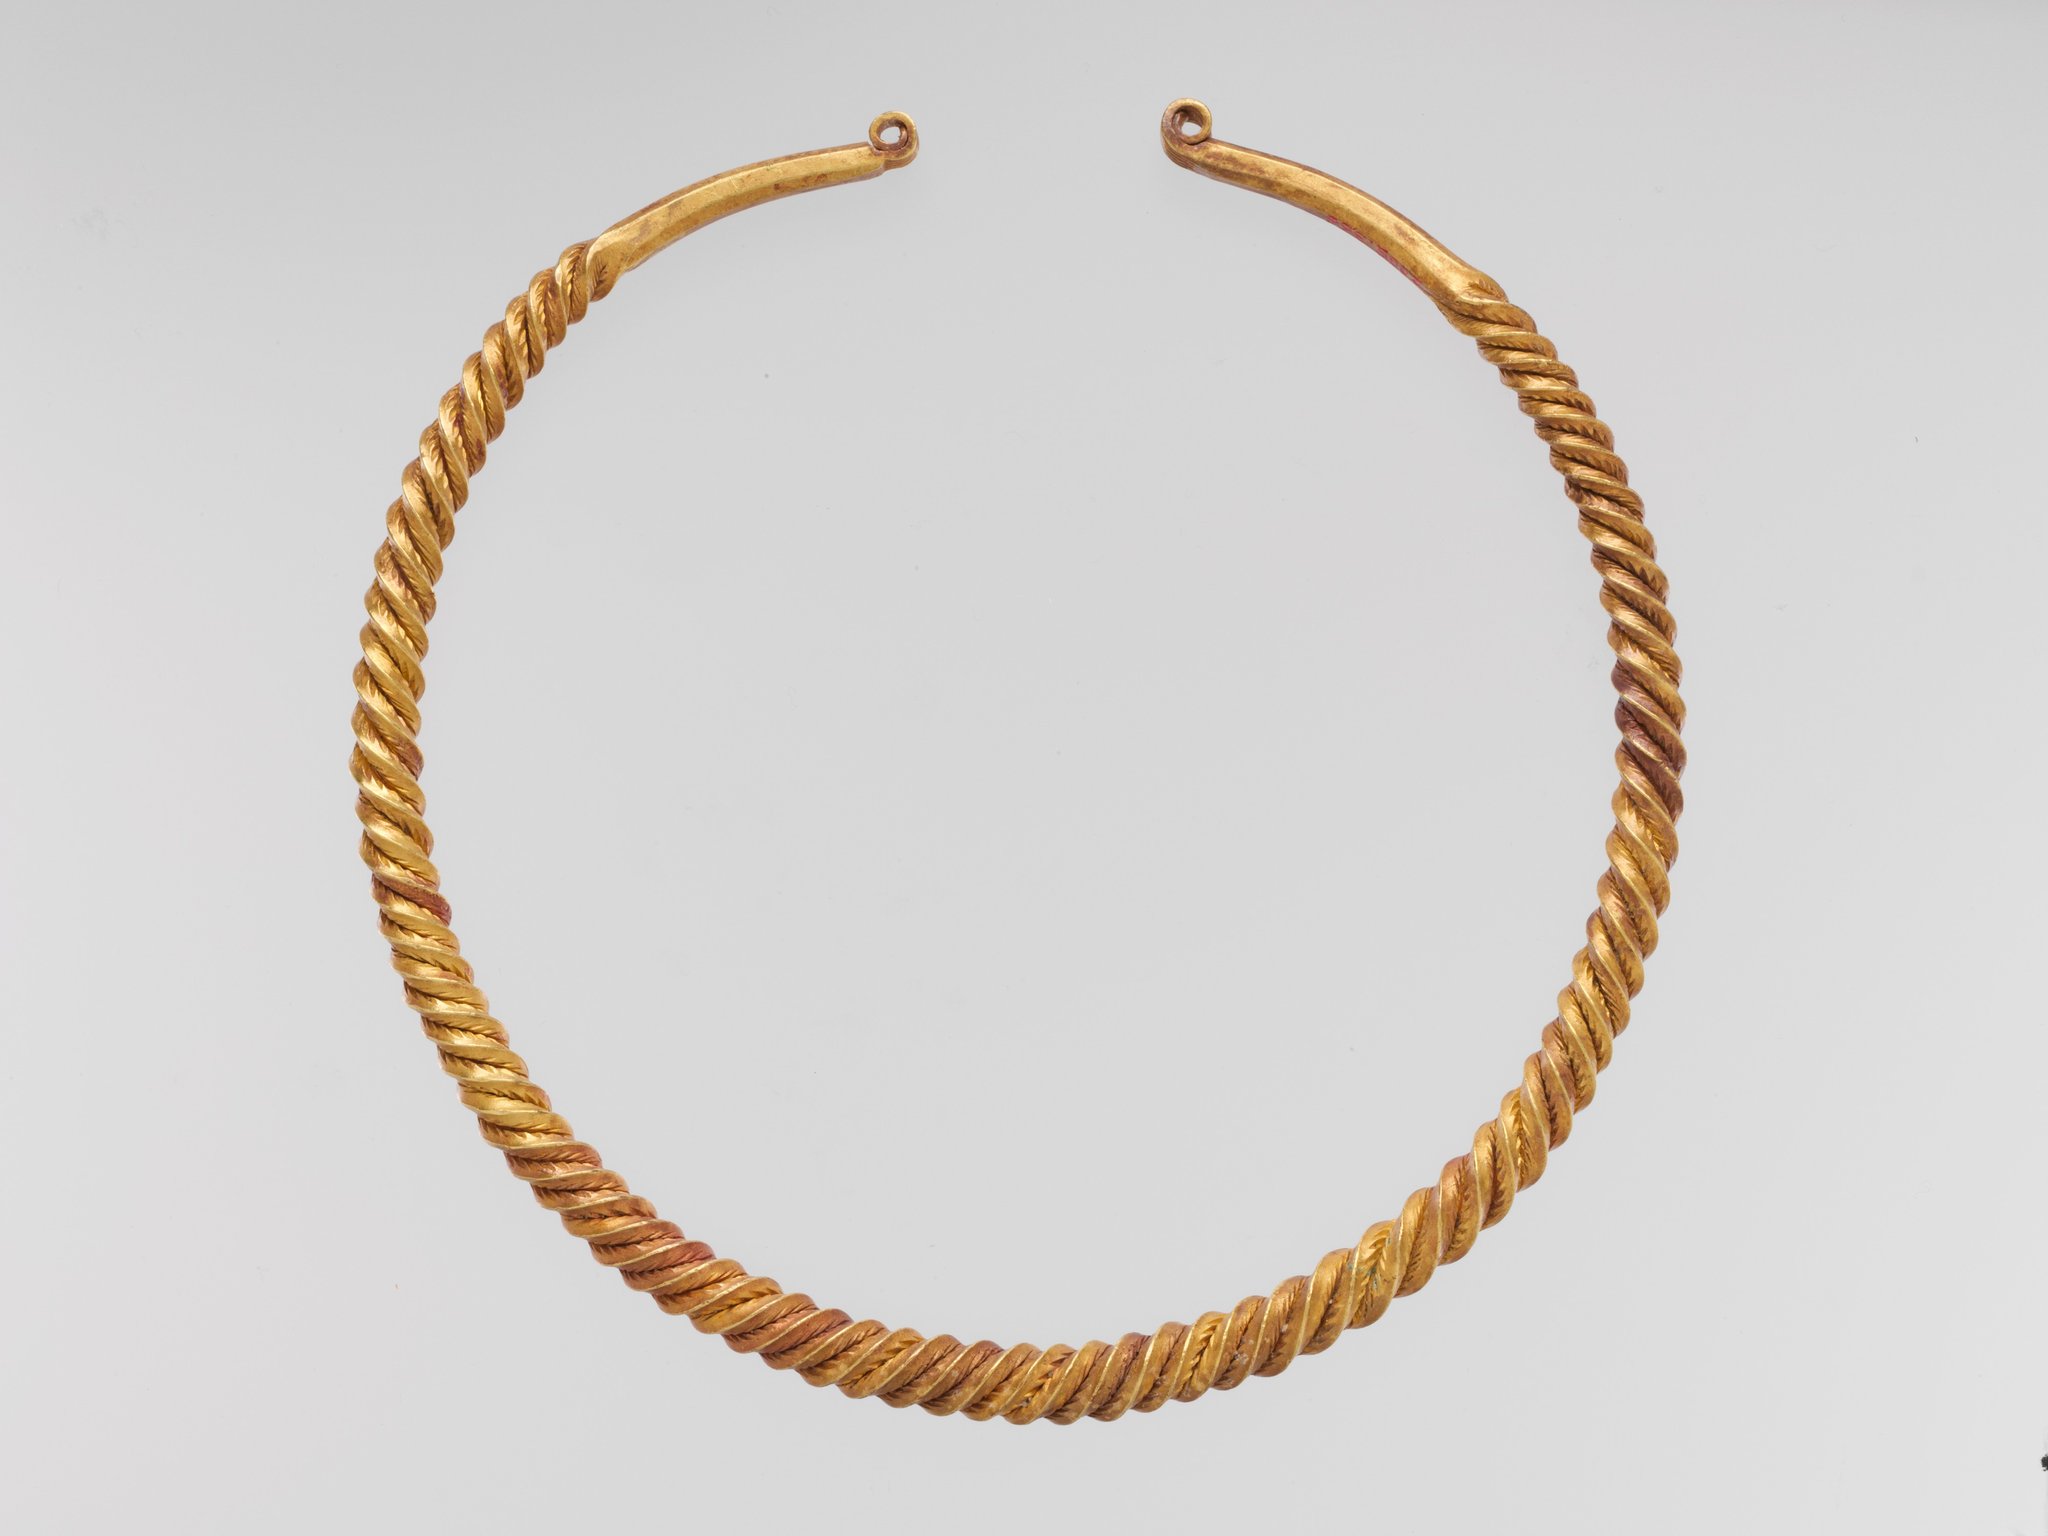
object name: neck ring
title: Gold Neck Ring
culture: celtic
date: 600-301 BCE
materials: gold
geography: russia